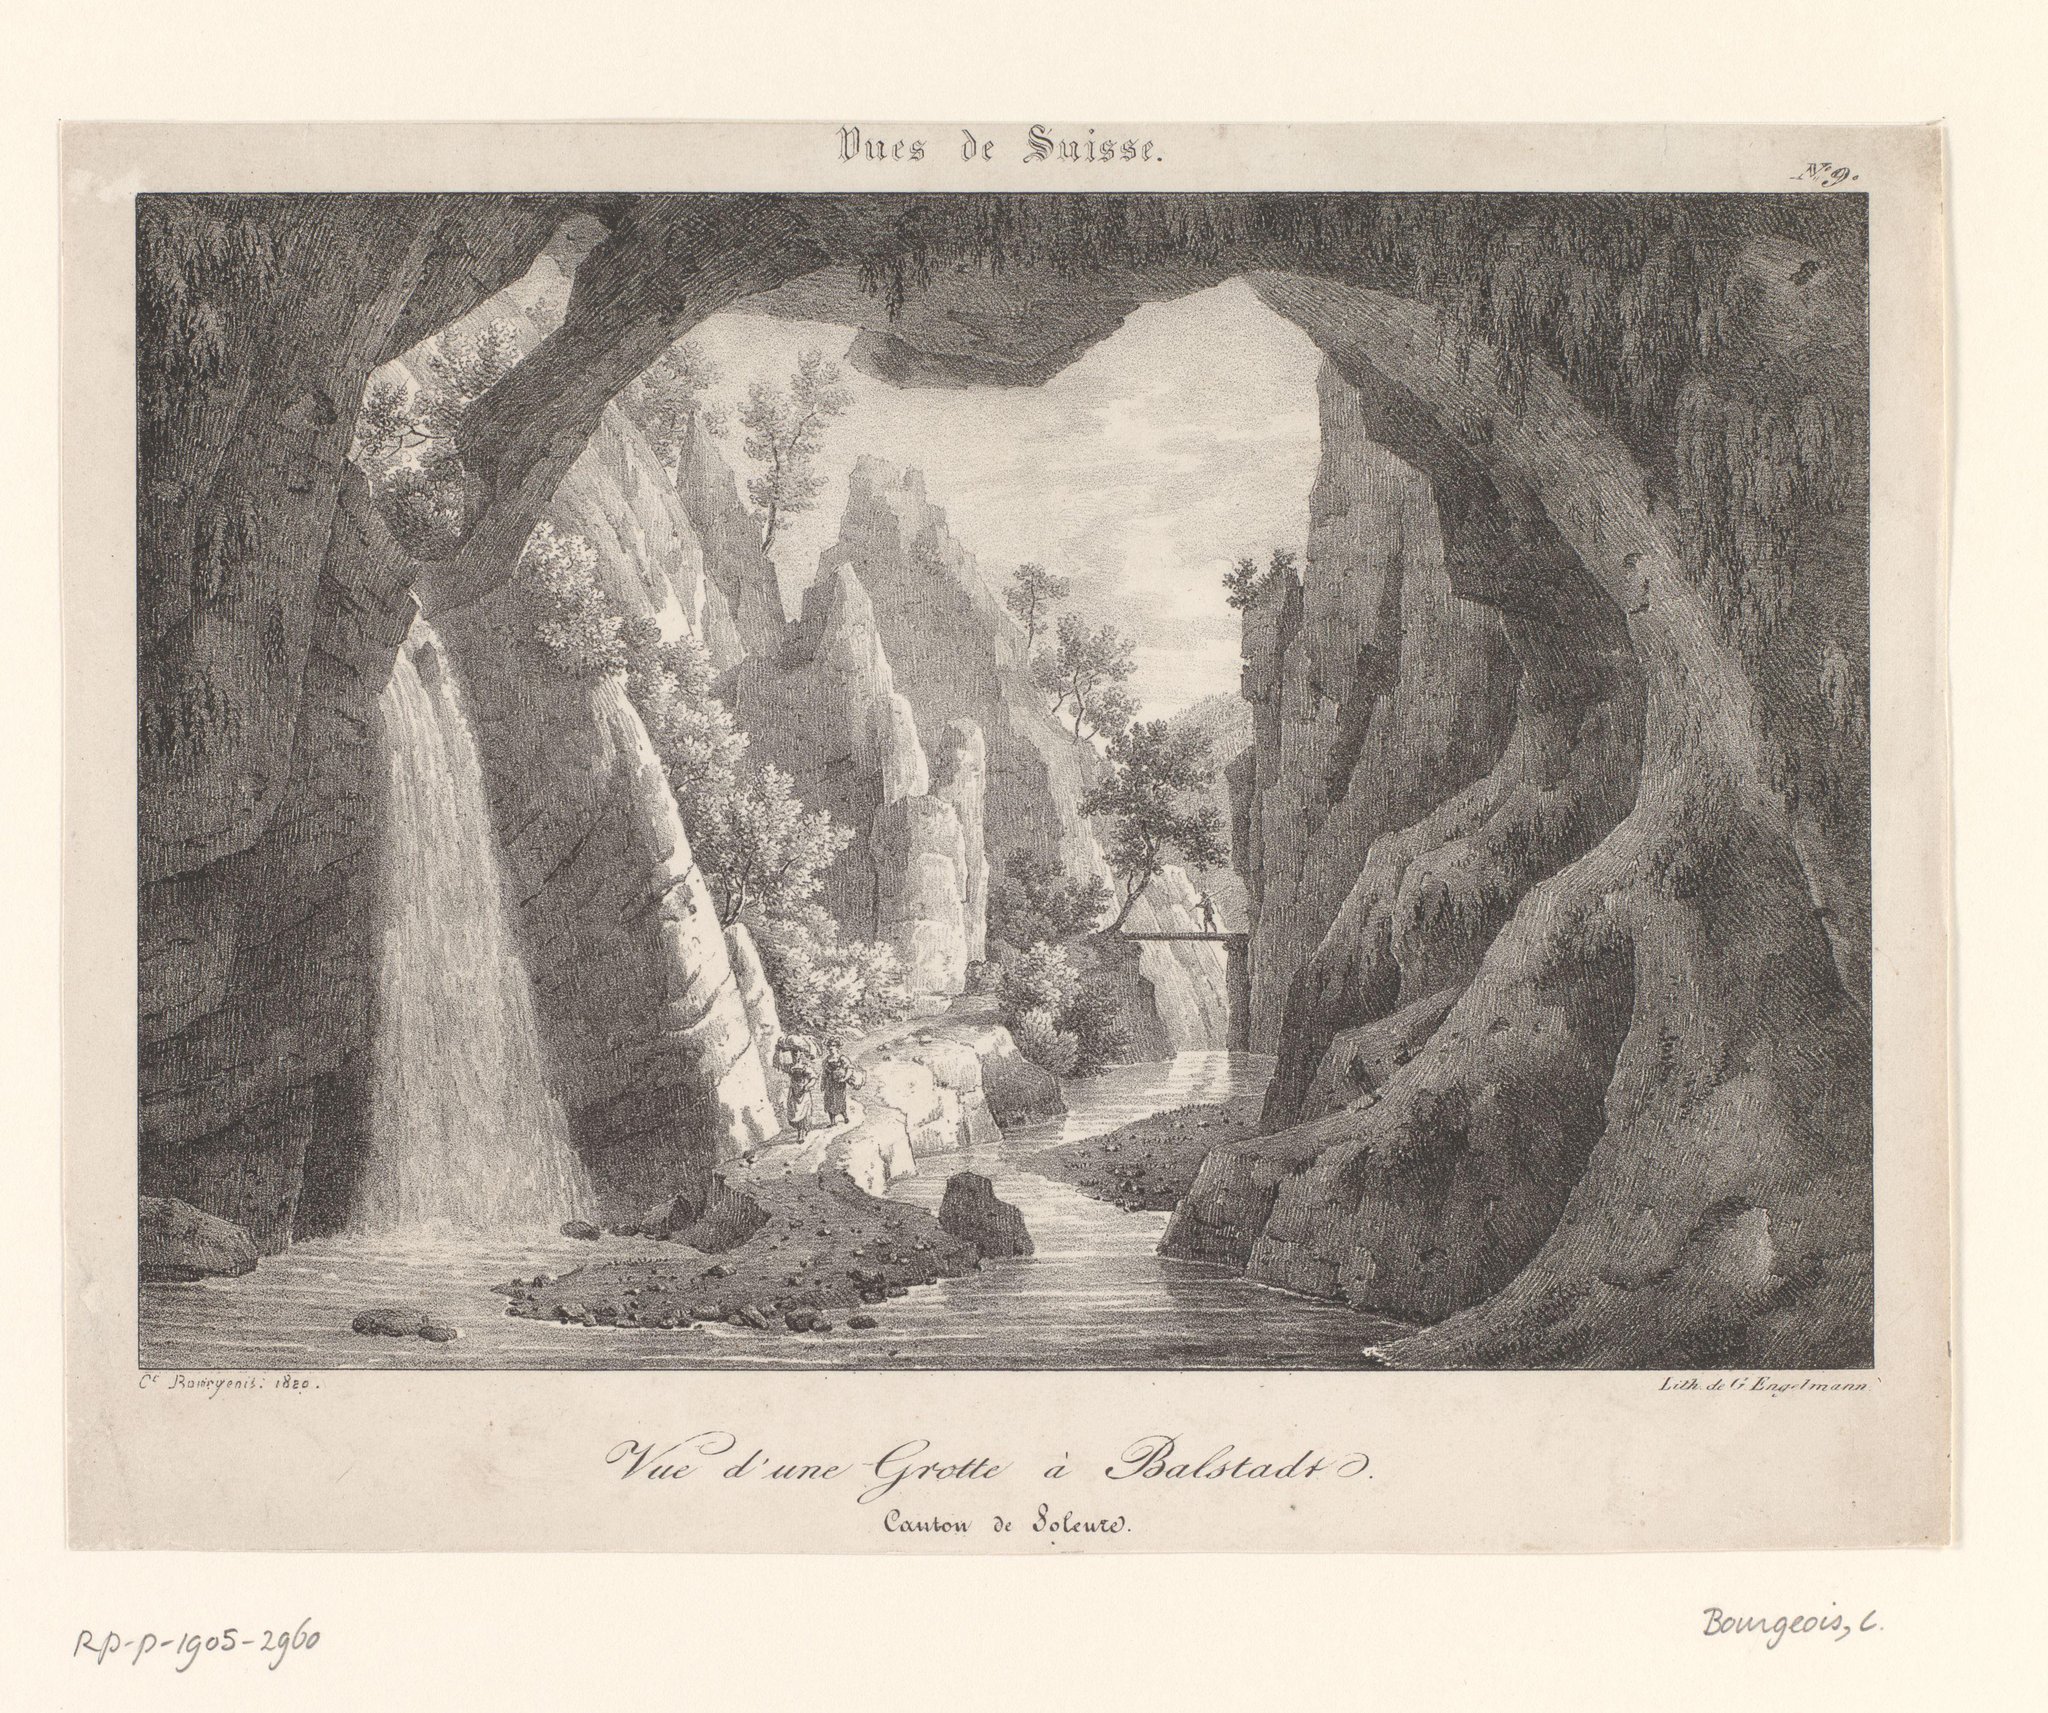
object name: print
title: Zicht op een grot met waterval bij Balsthal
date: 1820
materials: paper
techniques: lithograph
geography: paris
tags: waterfall, cave, grotto, mountains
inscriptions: collector's mark: Lugt 2228a